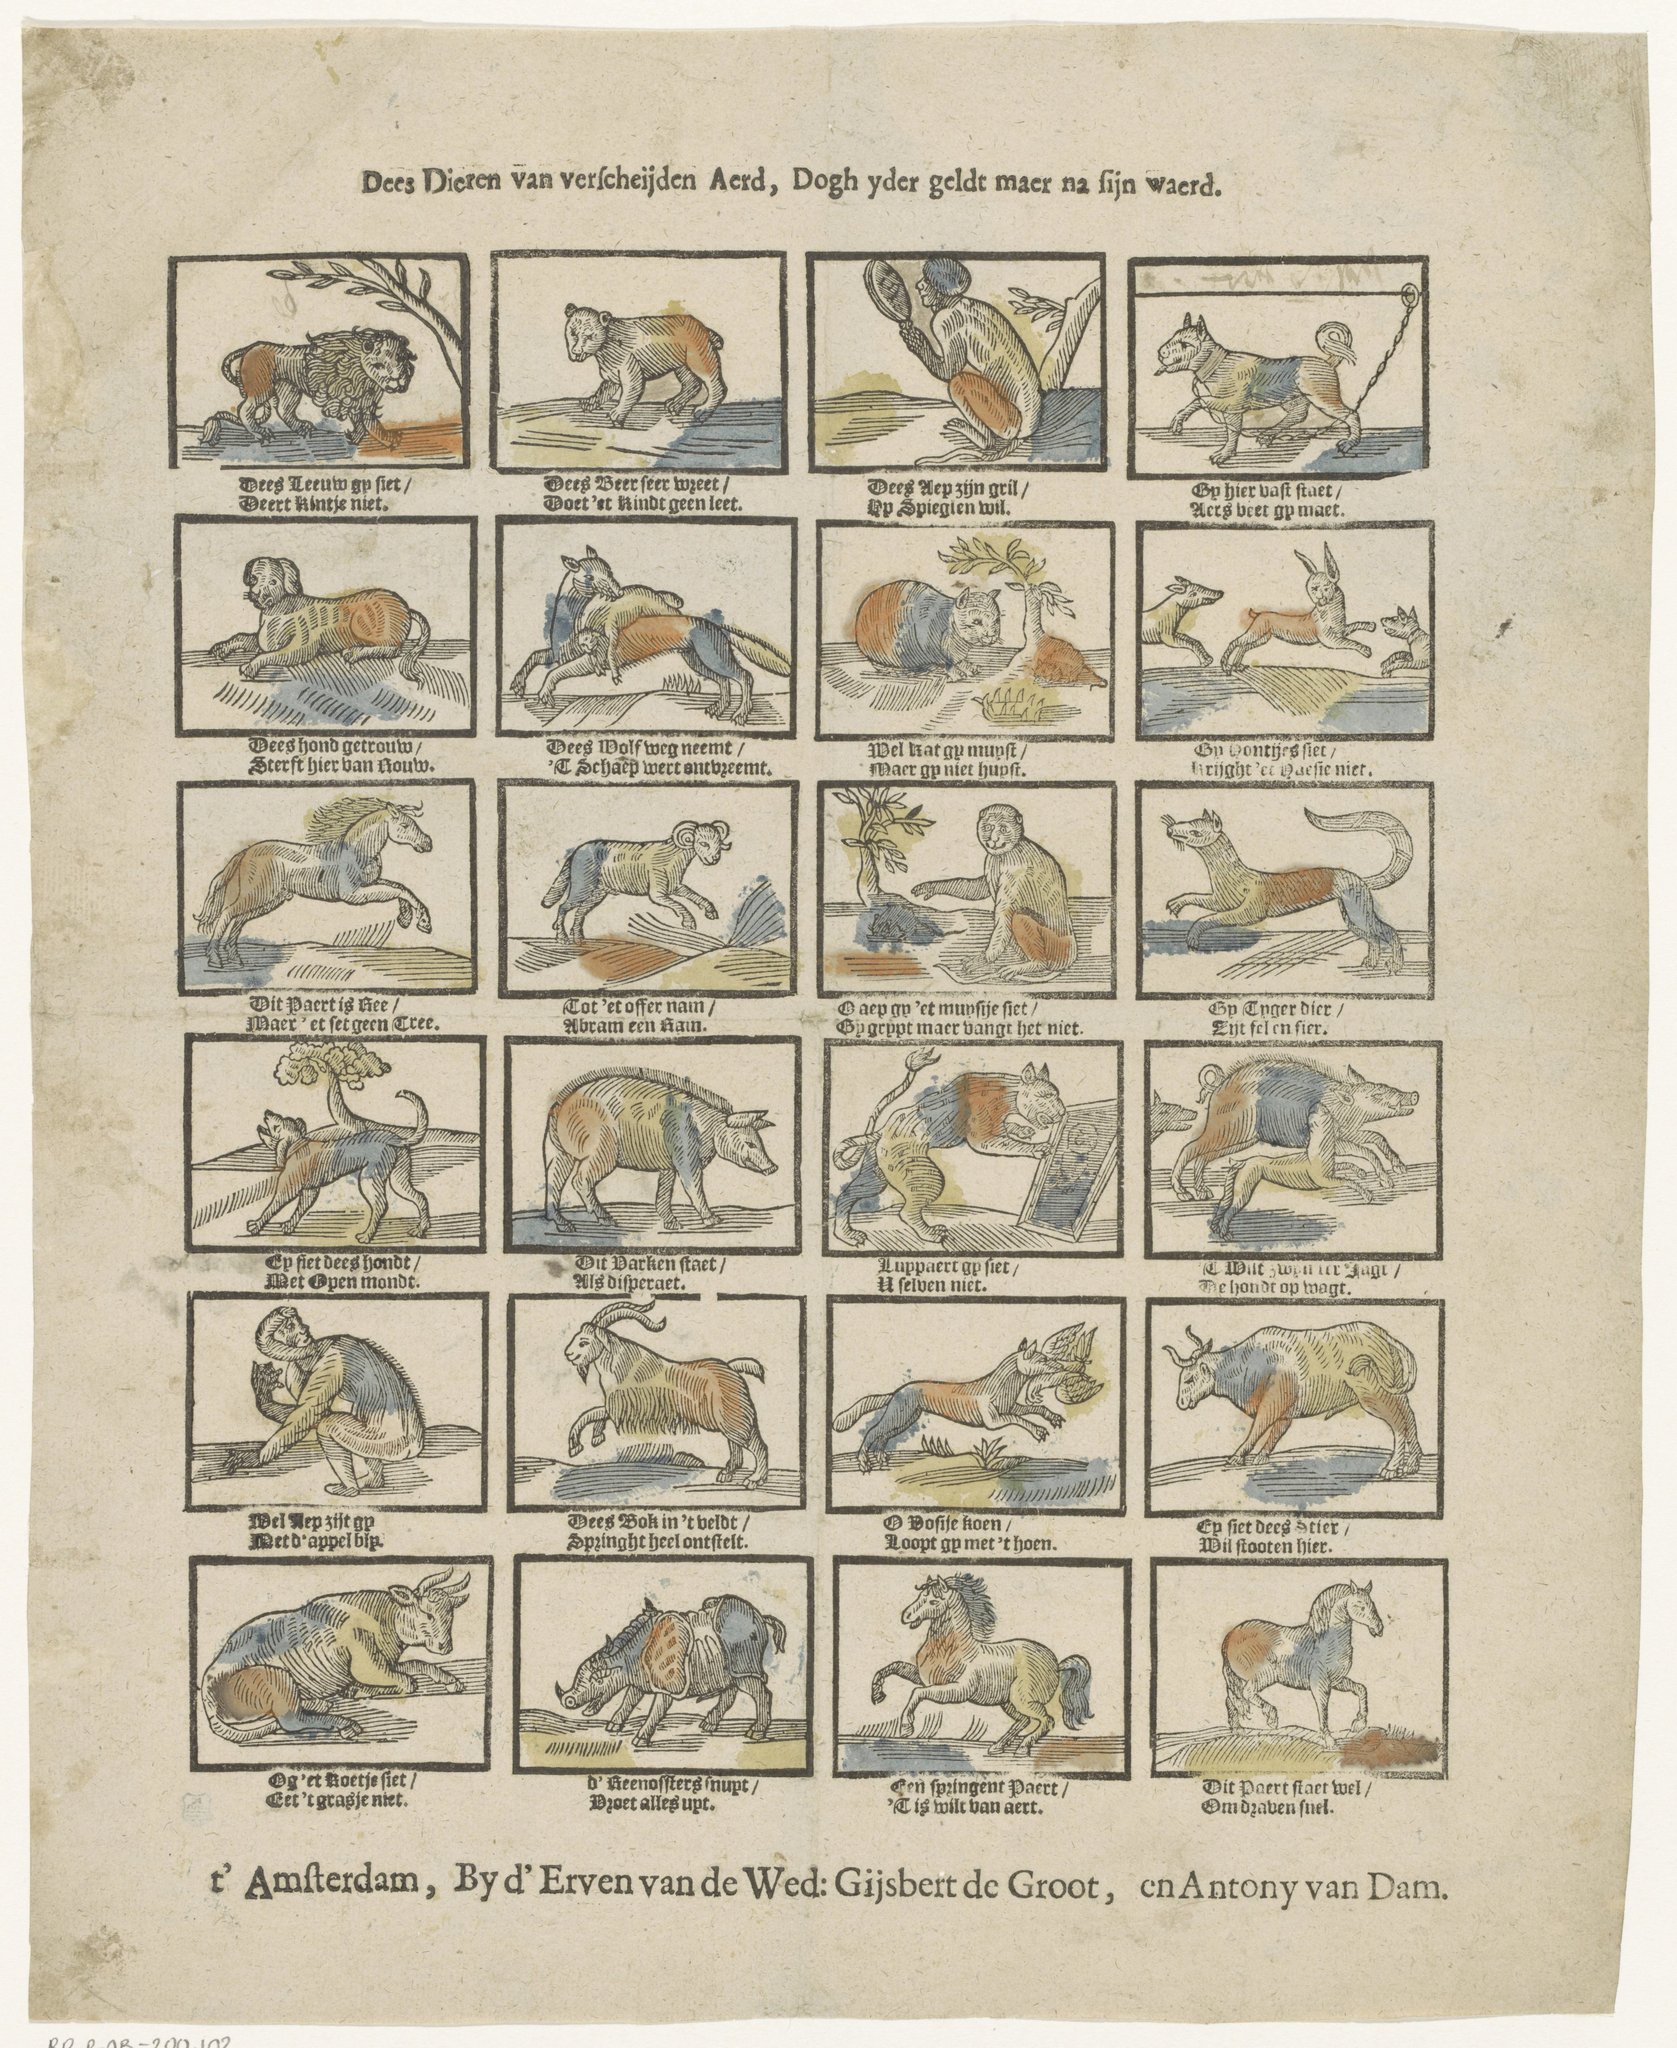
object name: popular print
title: Dees dieren van verscheijden aerd, Dogh yder geldt maer na sijn waerd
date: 1719-1724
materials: paper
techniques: colour, letterpress printing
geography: amsterdam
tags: animals, monkeys, apes, ram, beasts of prey, predatory animals: wolf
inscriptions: collector's mark: Lugt 2760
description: Blad met 24 voorstellingen van dieren, waaronder een wolf, een ram en een aap. Onder elke afbeelding een tweeregelig vers.